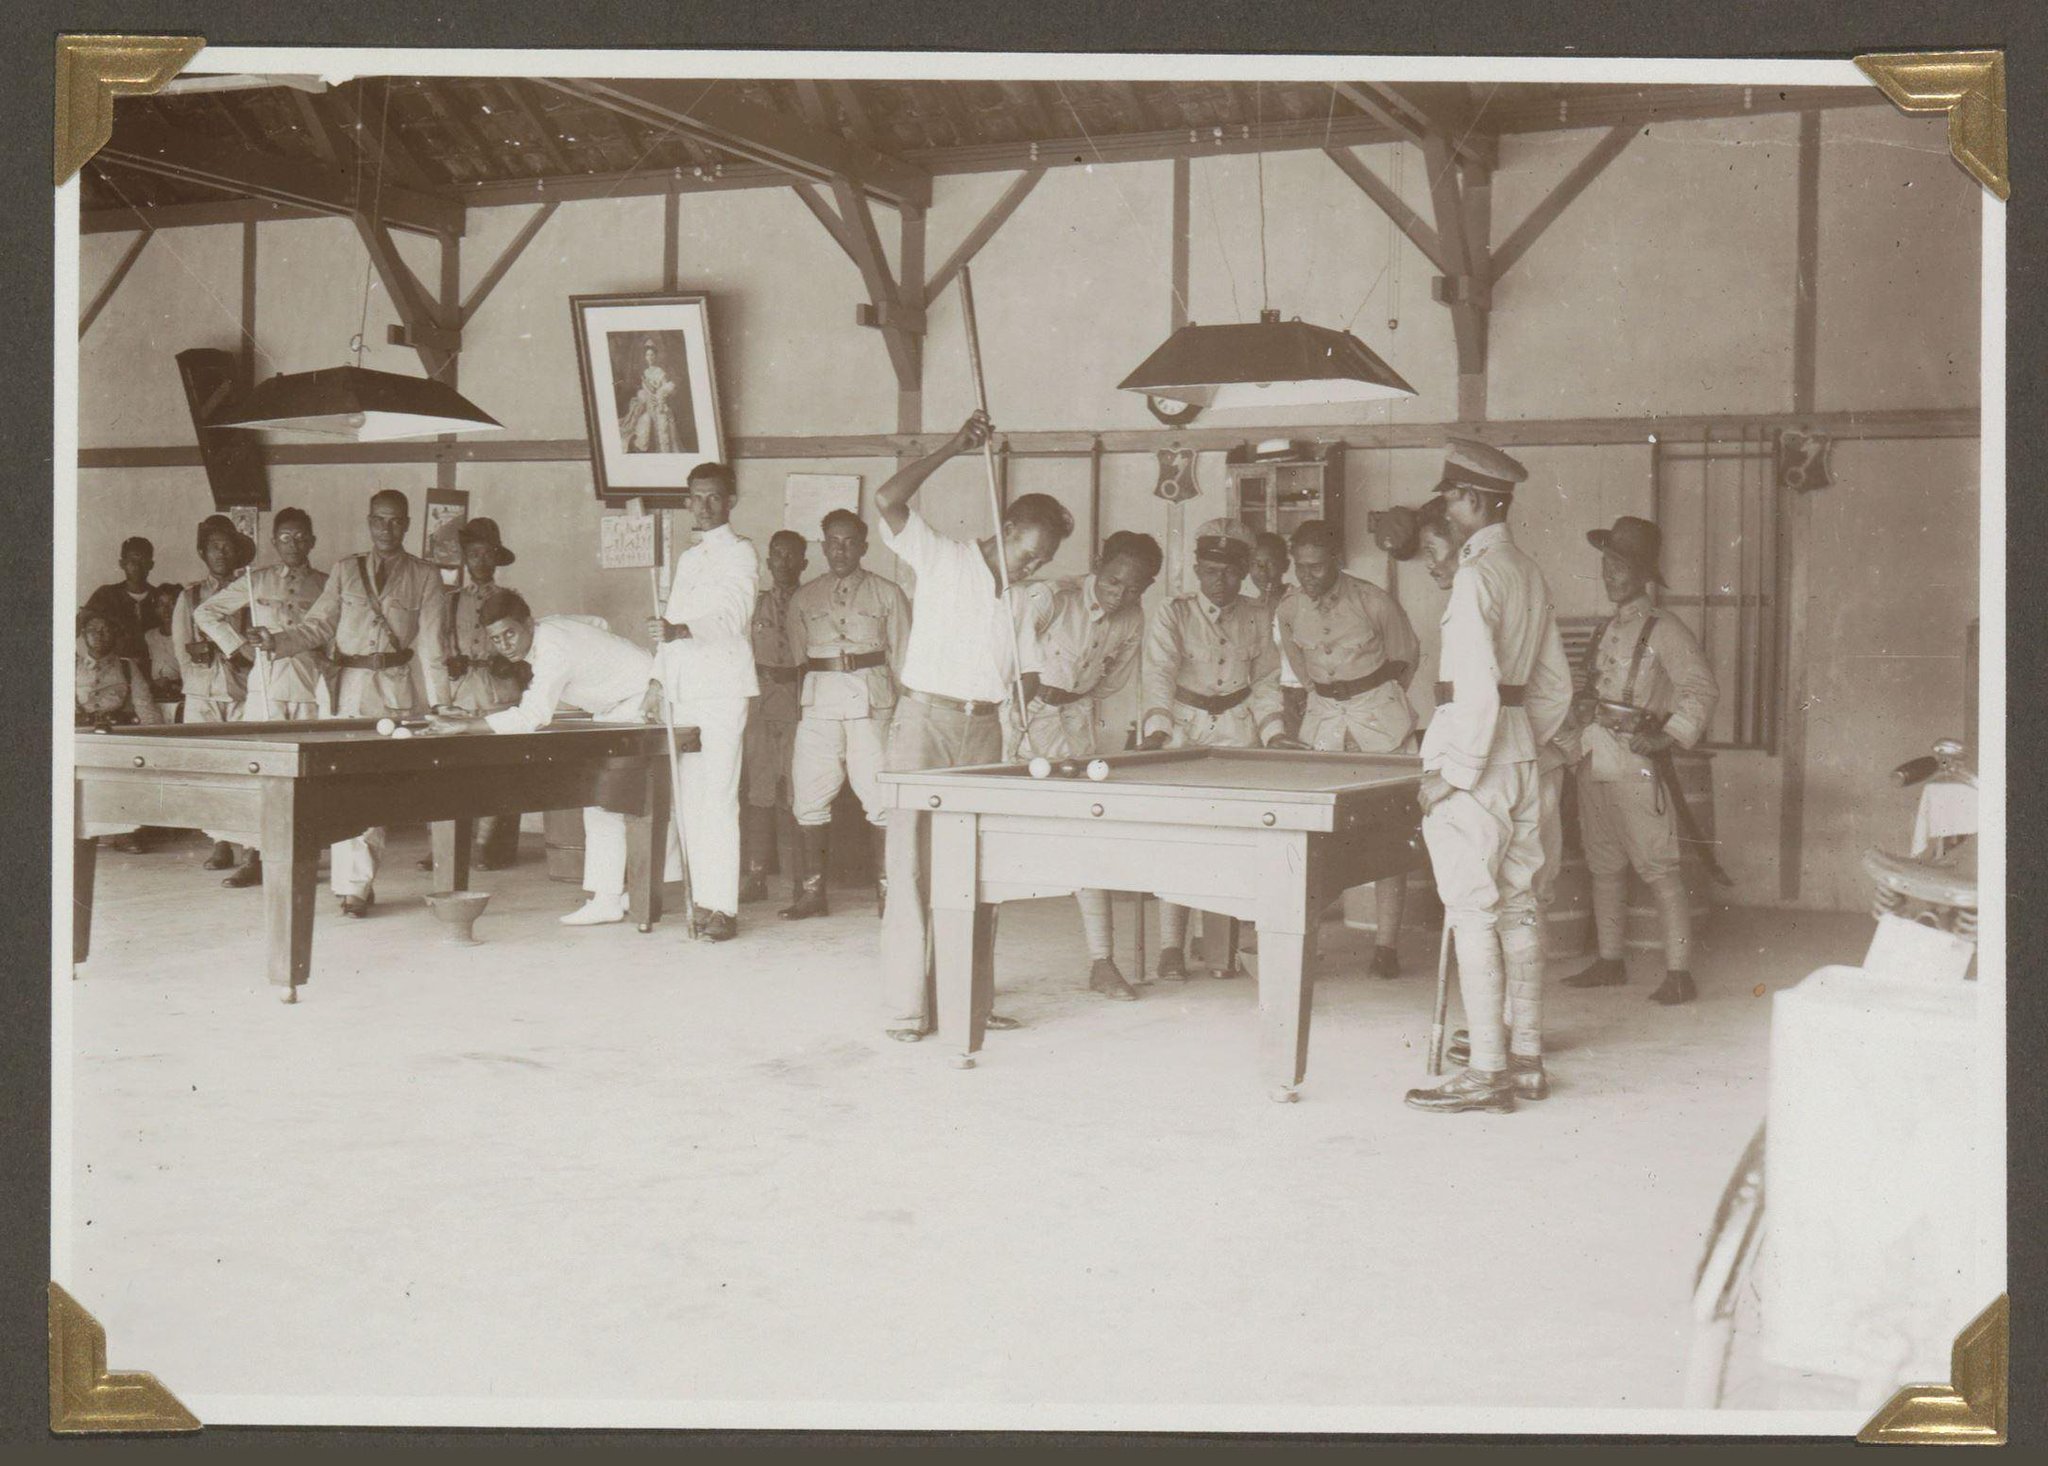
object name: photograph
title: Biljartende politieagenten in Lampong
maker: Anonymous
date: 1932-1933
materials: photographic support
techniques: gelatin silver print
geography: lampung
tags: billiards, police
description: Onderdeel van Herinneringsalbum voor F.J. Junius, vertrekkend resident van Lampong (Zuid-Sumatra).